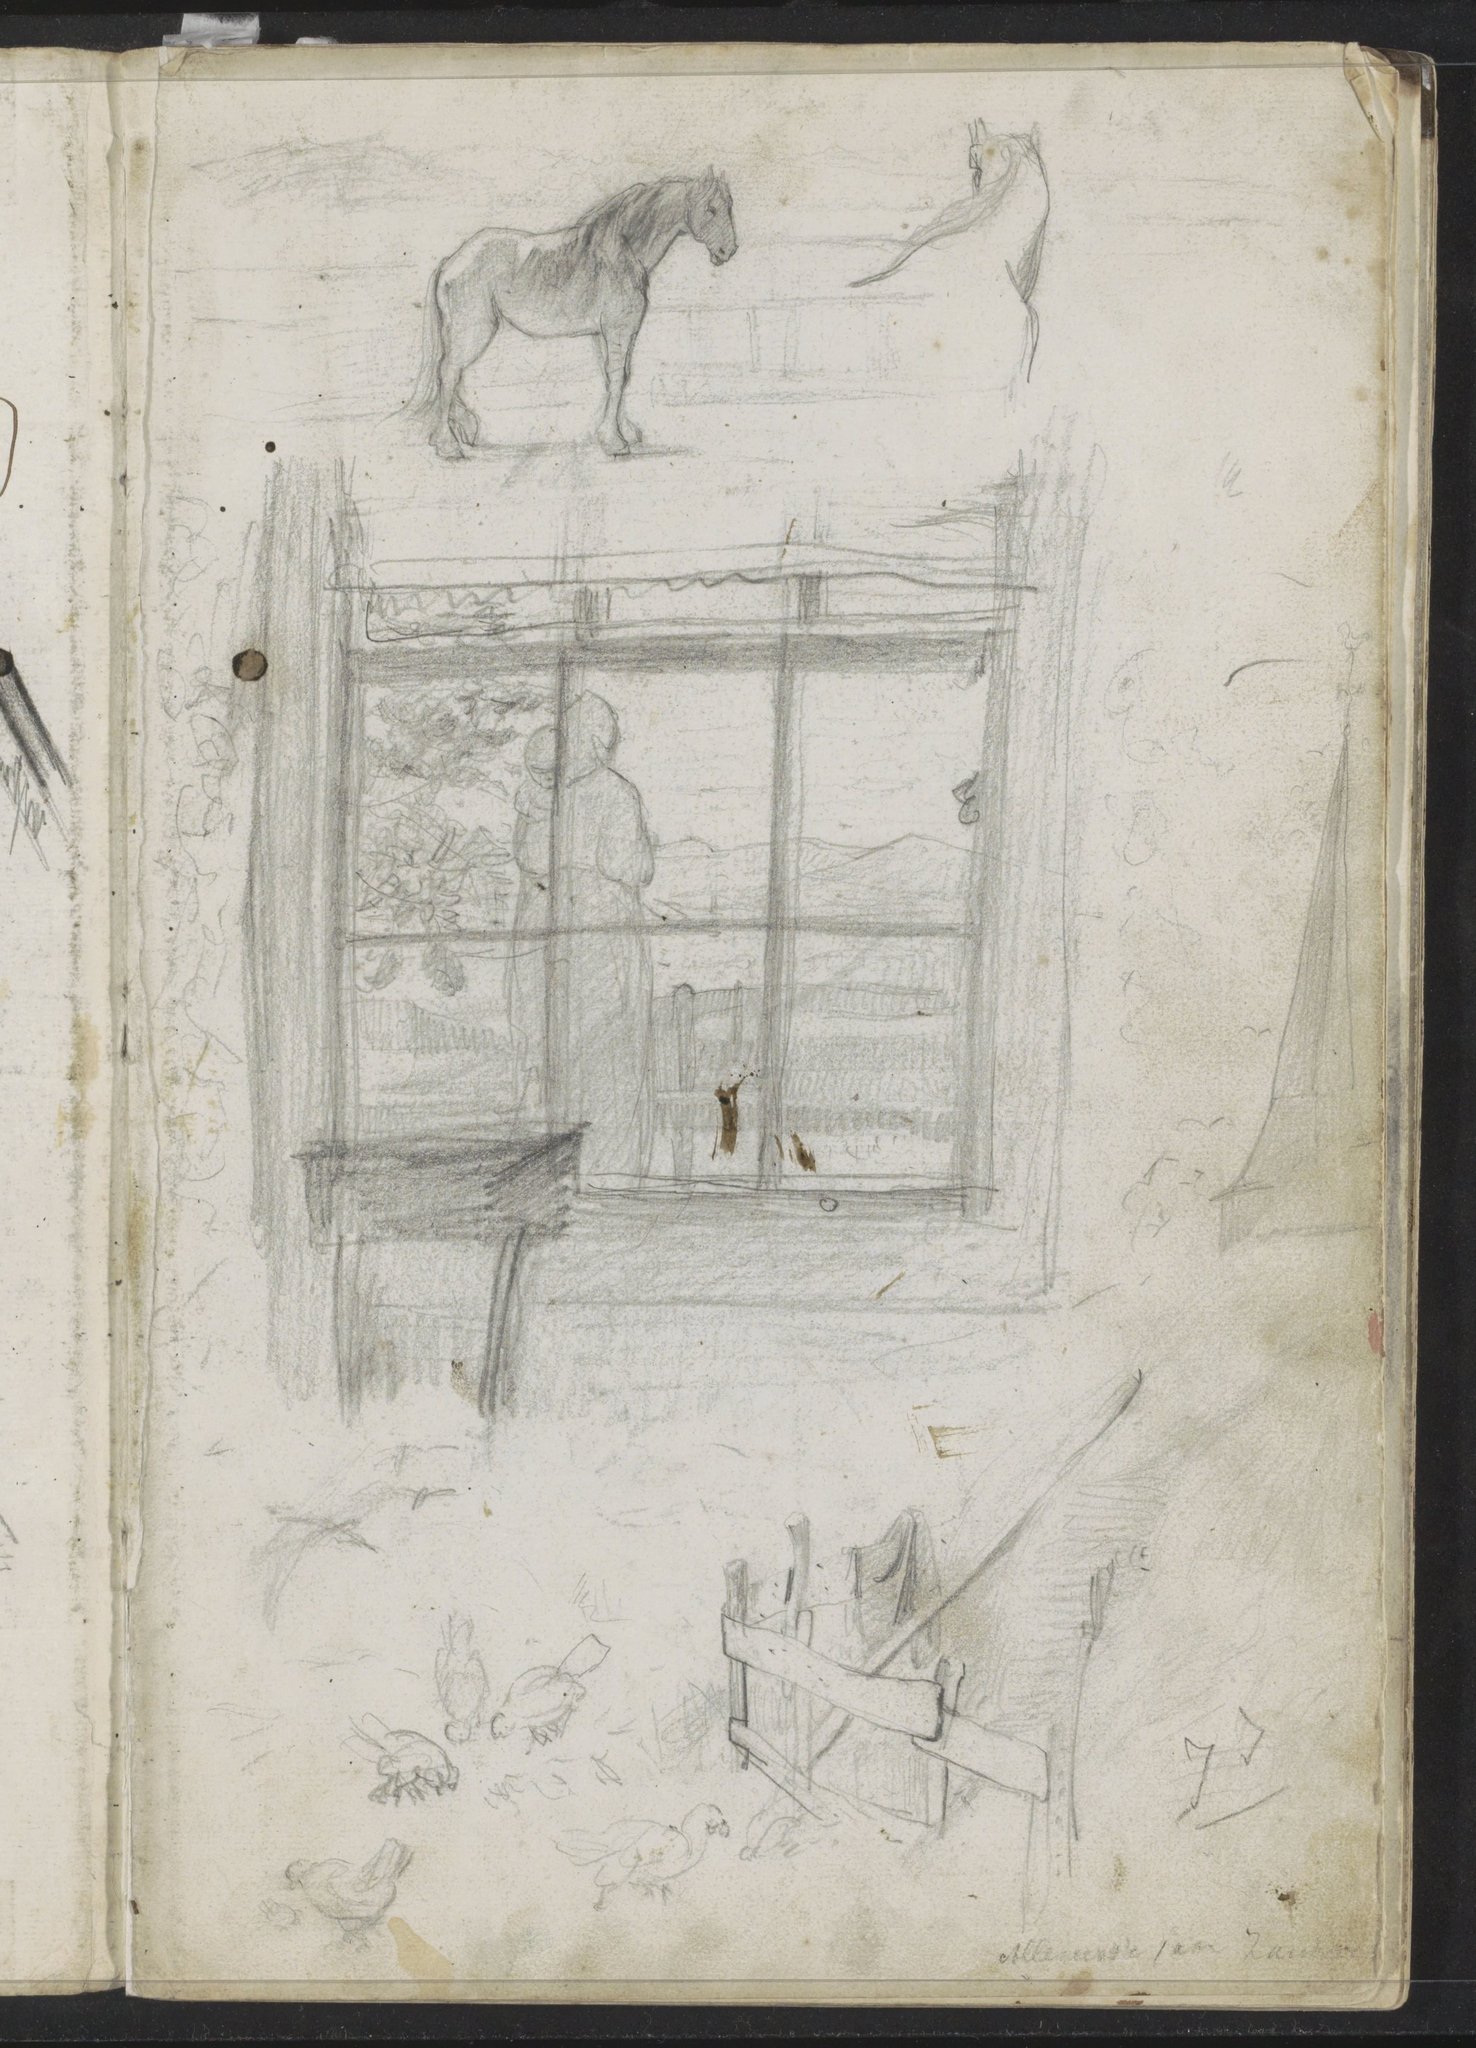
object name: sketchbook leaf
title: Paard, kippen bij een hek en een vrouw gezien door een venster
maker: jozef israëls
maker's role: draughtsman, painter, print maker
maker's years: 1824-1911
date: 1855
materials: paper, pencil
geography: zandvoort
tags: window, fowl (cock, hen, chicken, etc.), horse, landscapes (+ landscape with figures, staffage)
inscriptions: annotation: ‘allereerste jaar Zandvoort’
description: Blad 1 recto uit een schetsboek met 22 bladen.